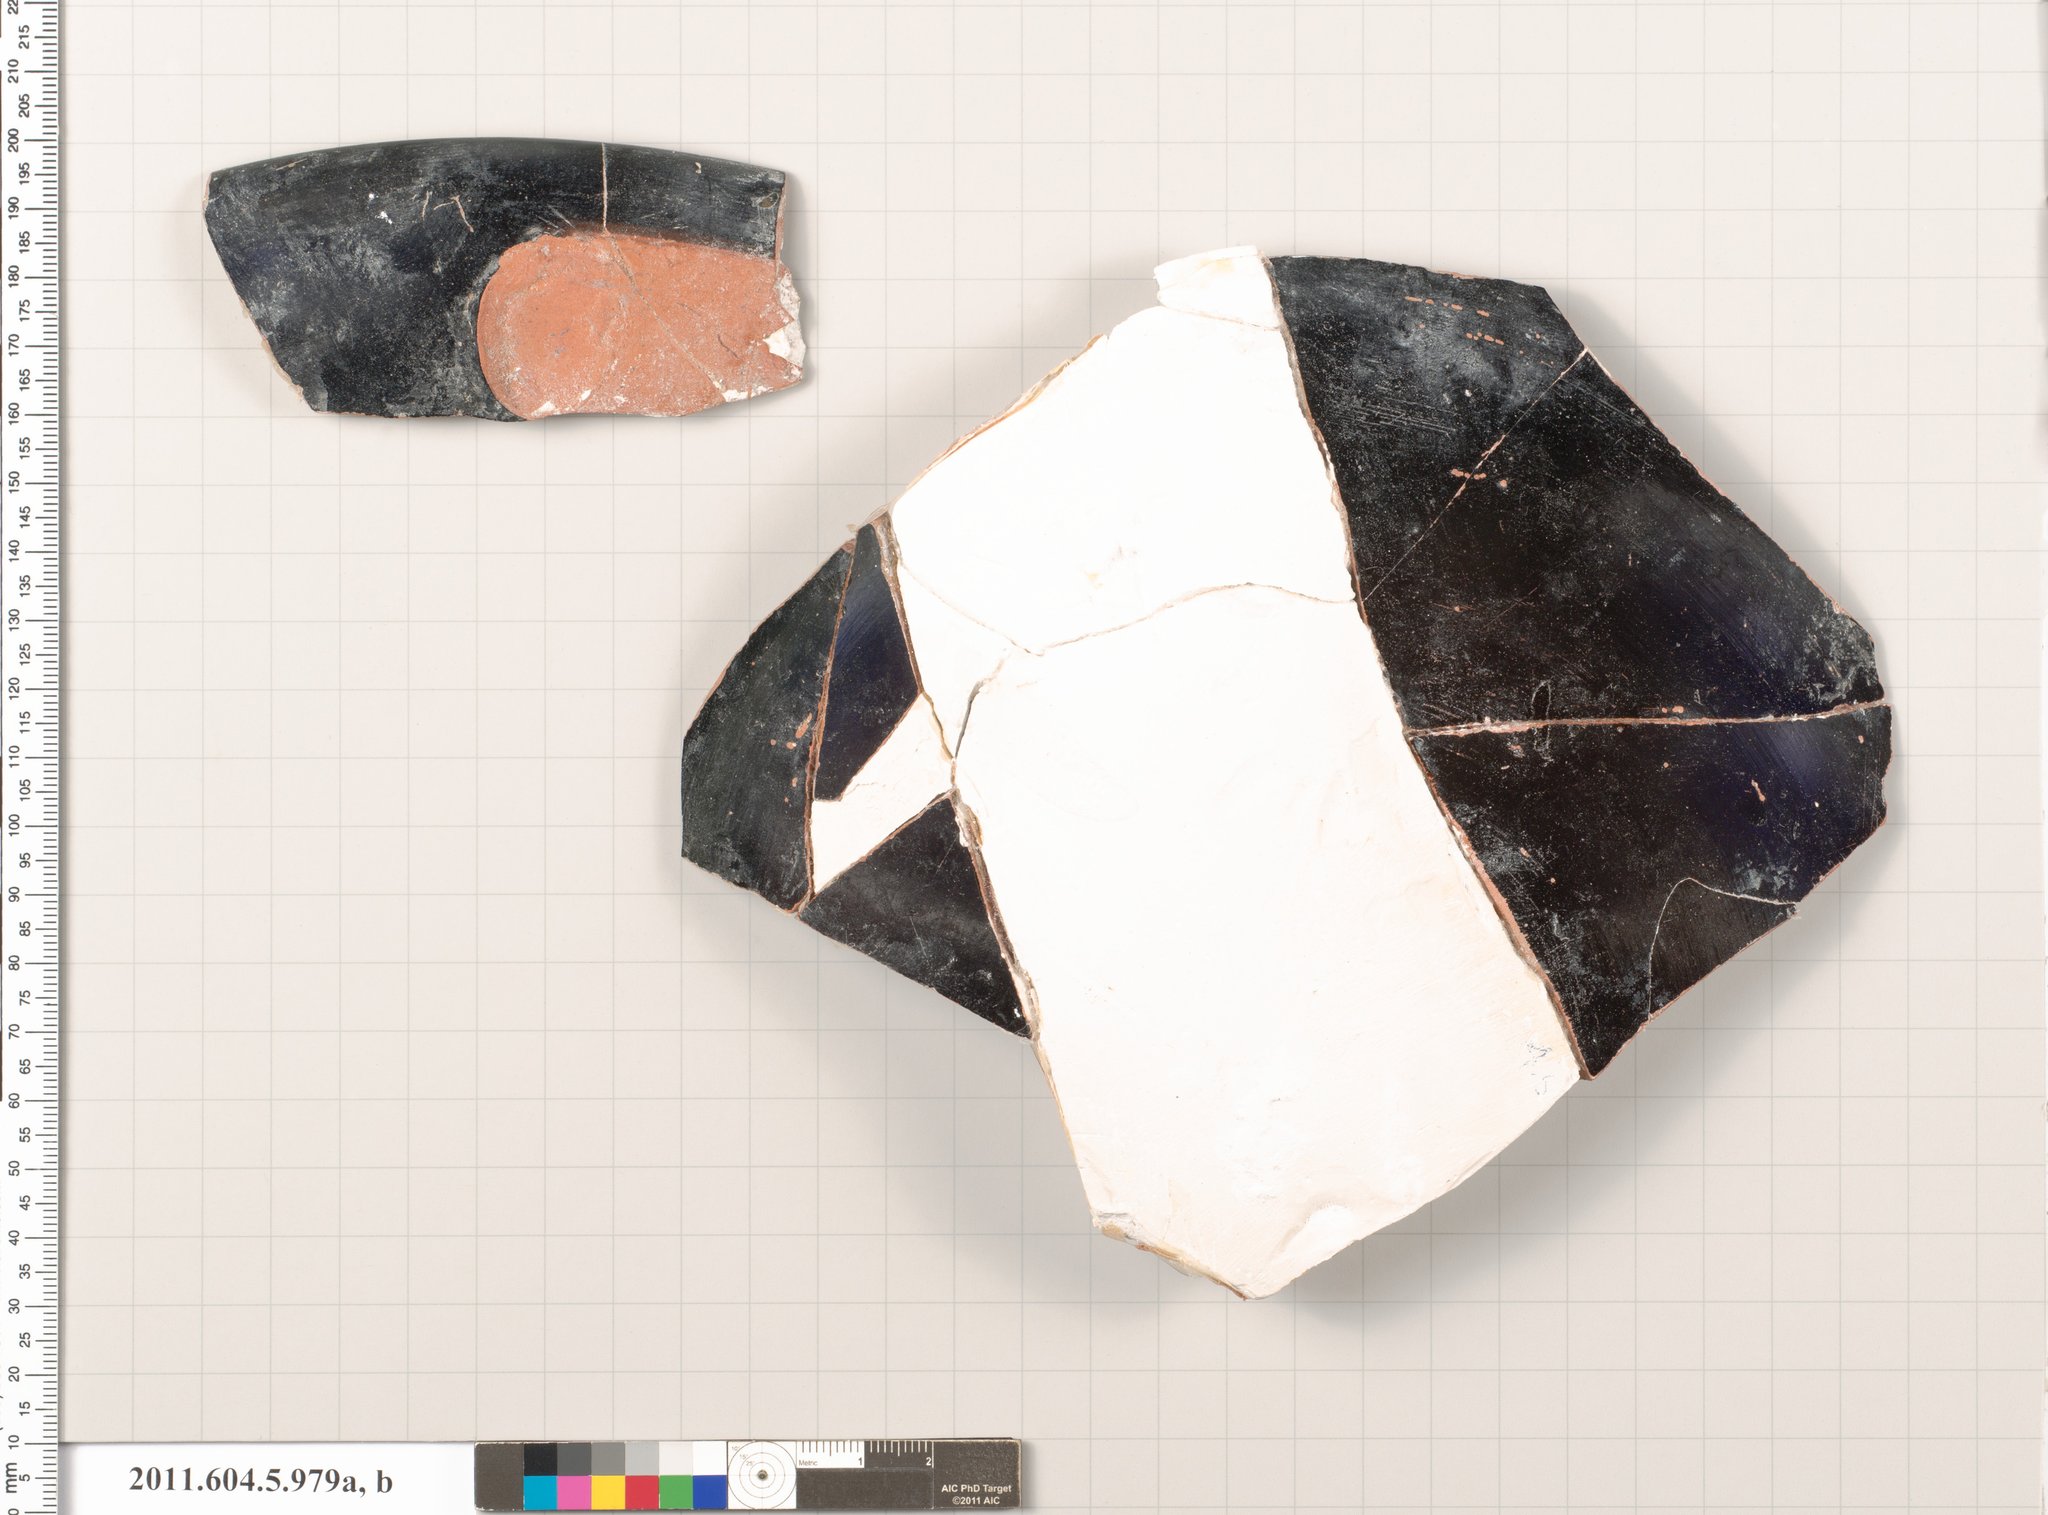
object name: kylix fragment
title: Terracotta fragments of a kylix (drinking cup)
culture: greek, attic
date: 600-401 BCE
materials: terracotta